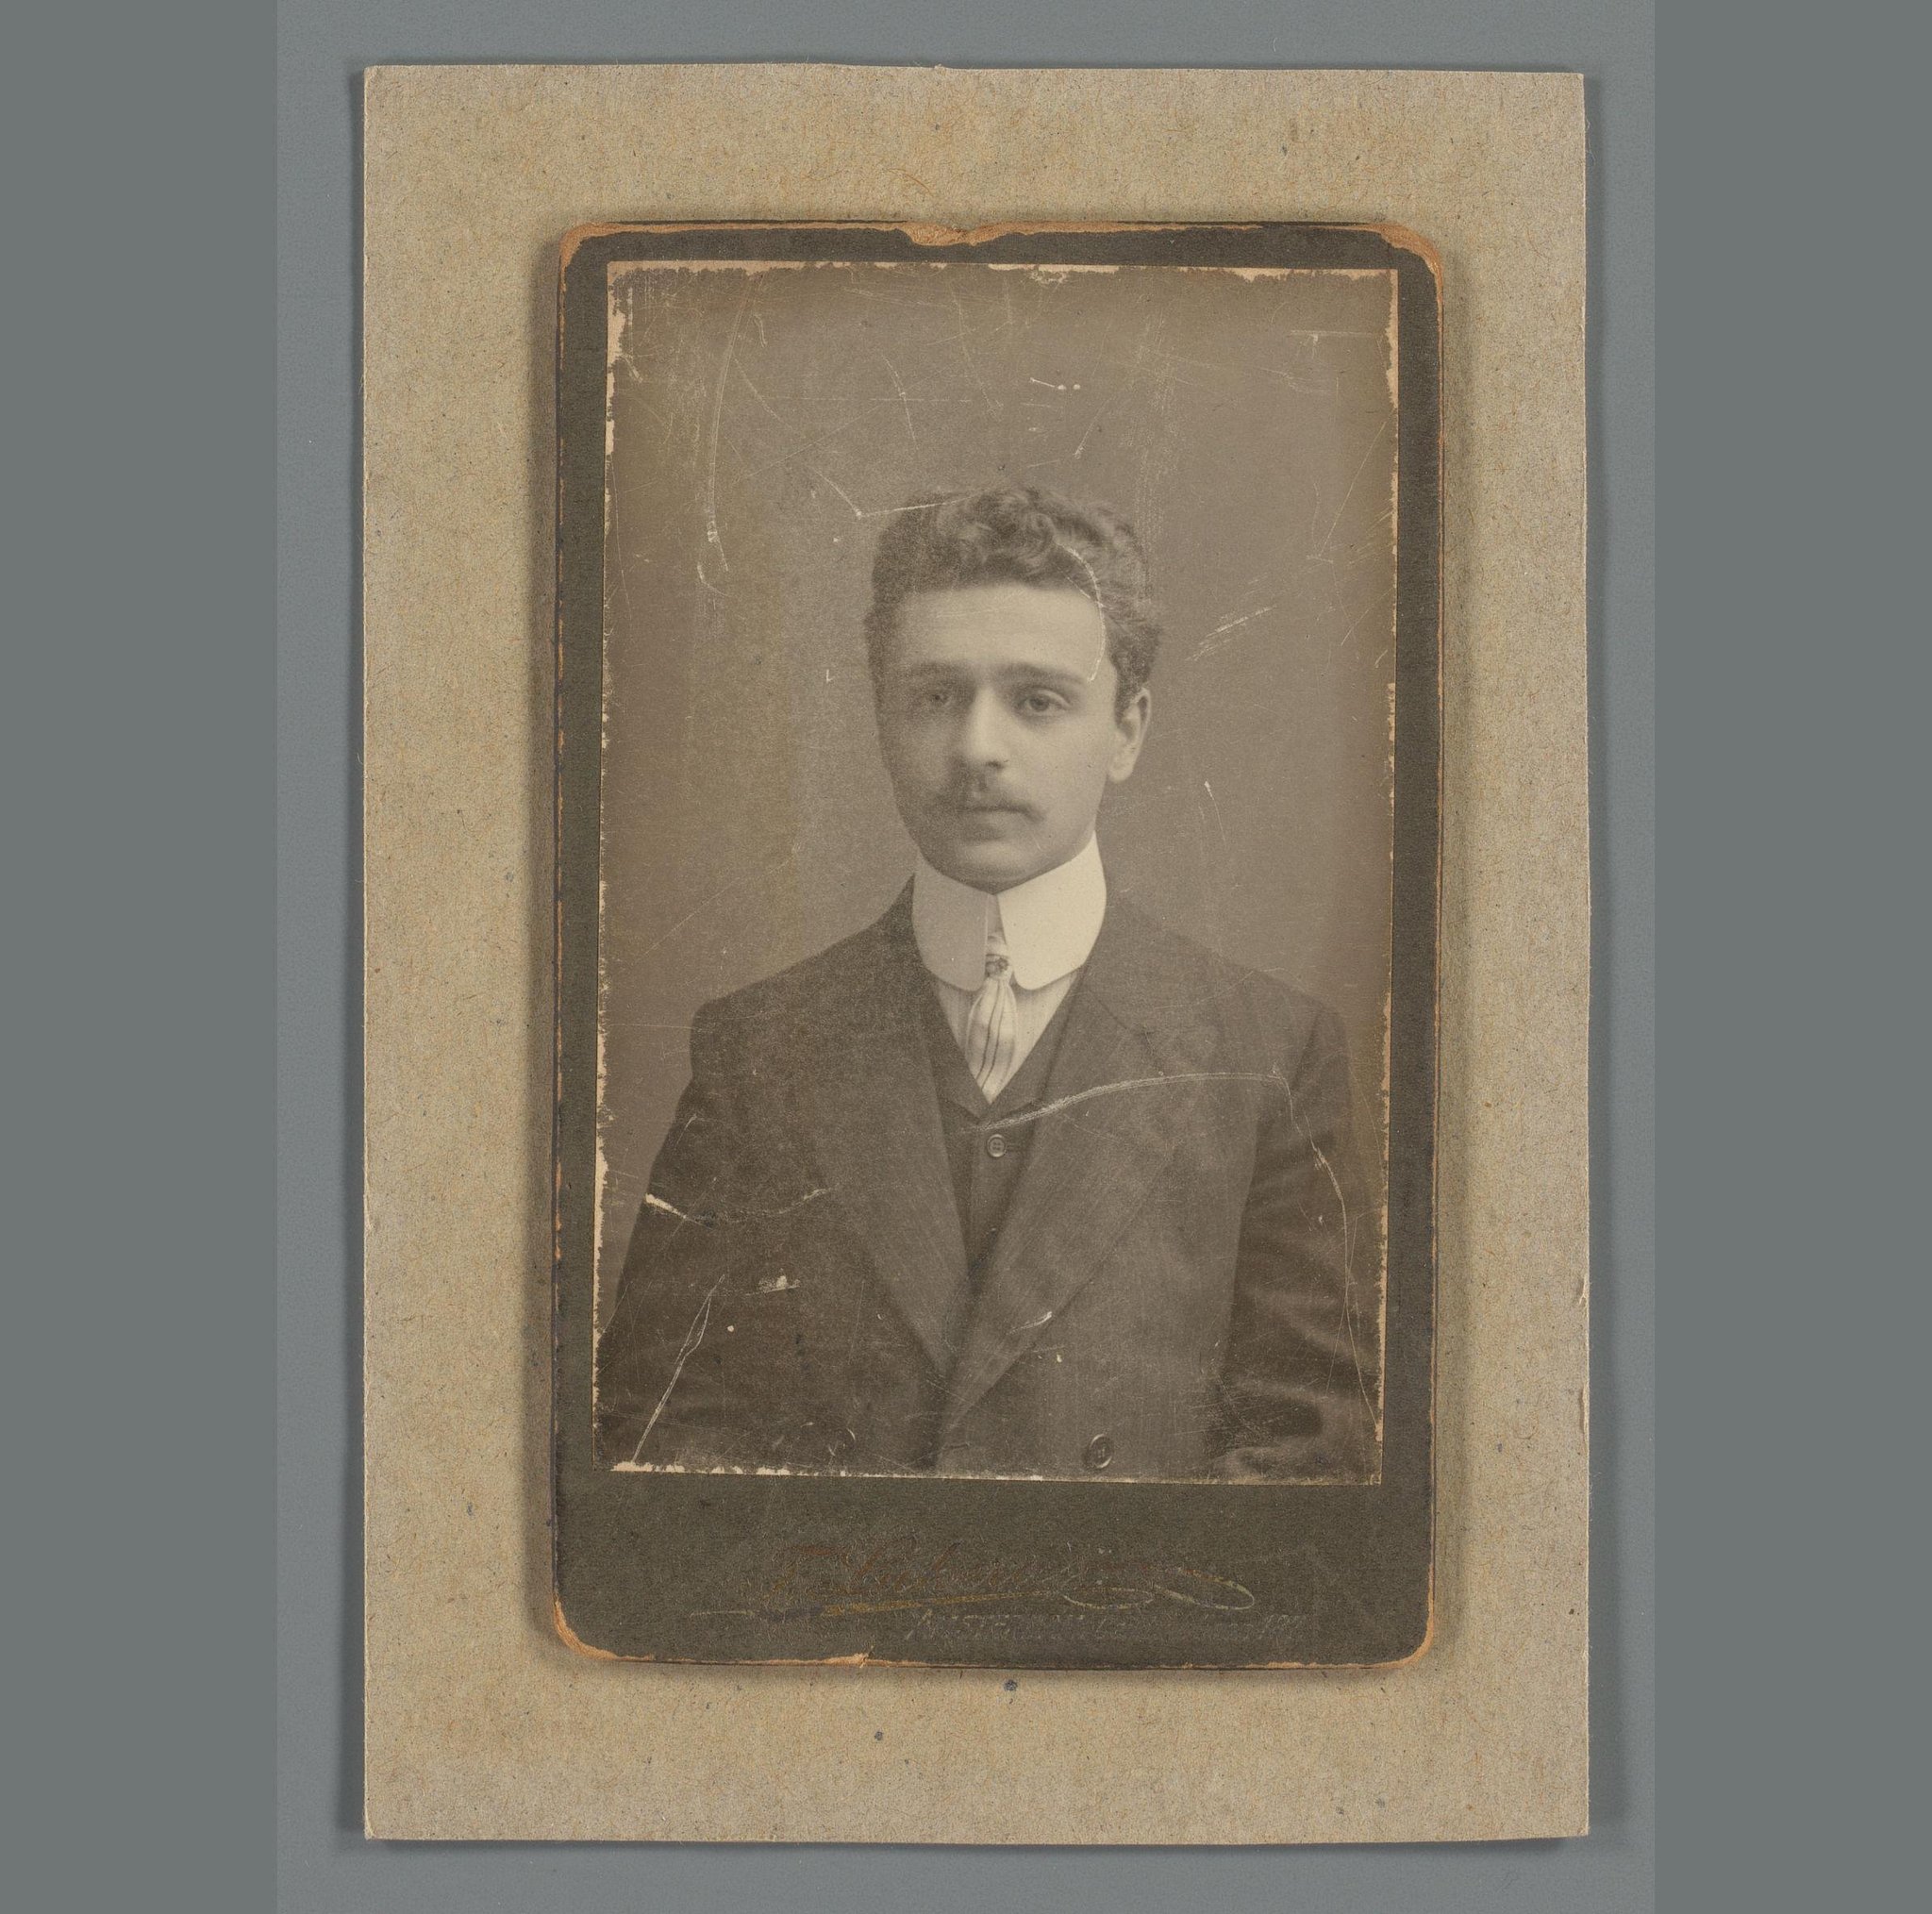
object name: photograph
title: Portret van een onbekende man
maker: franciscus g. lukera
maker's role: fotograaf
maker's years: 1853-1927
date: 1896-1920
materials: paper, cardboard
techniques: gelatin silver print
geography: amsterdam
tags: historical persons not known by name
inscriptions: inscription: ‘F. Lukera/ Amsterdam Ceintuurbaan 187’